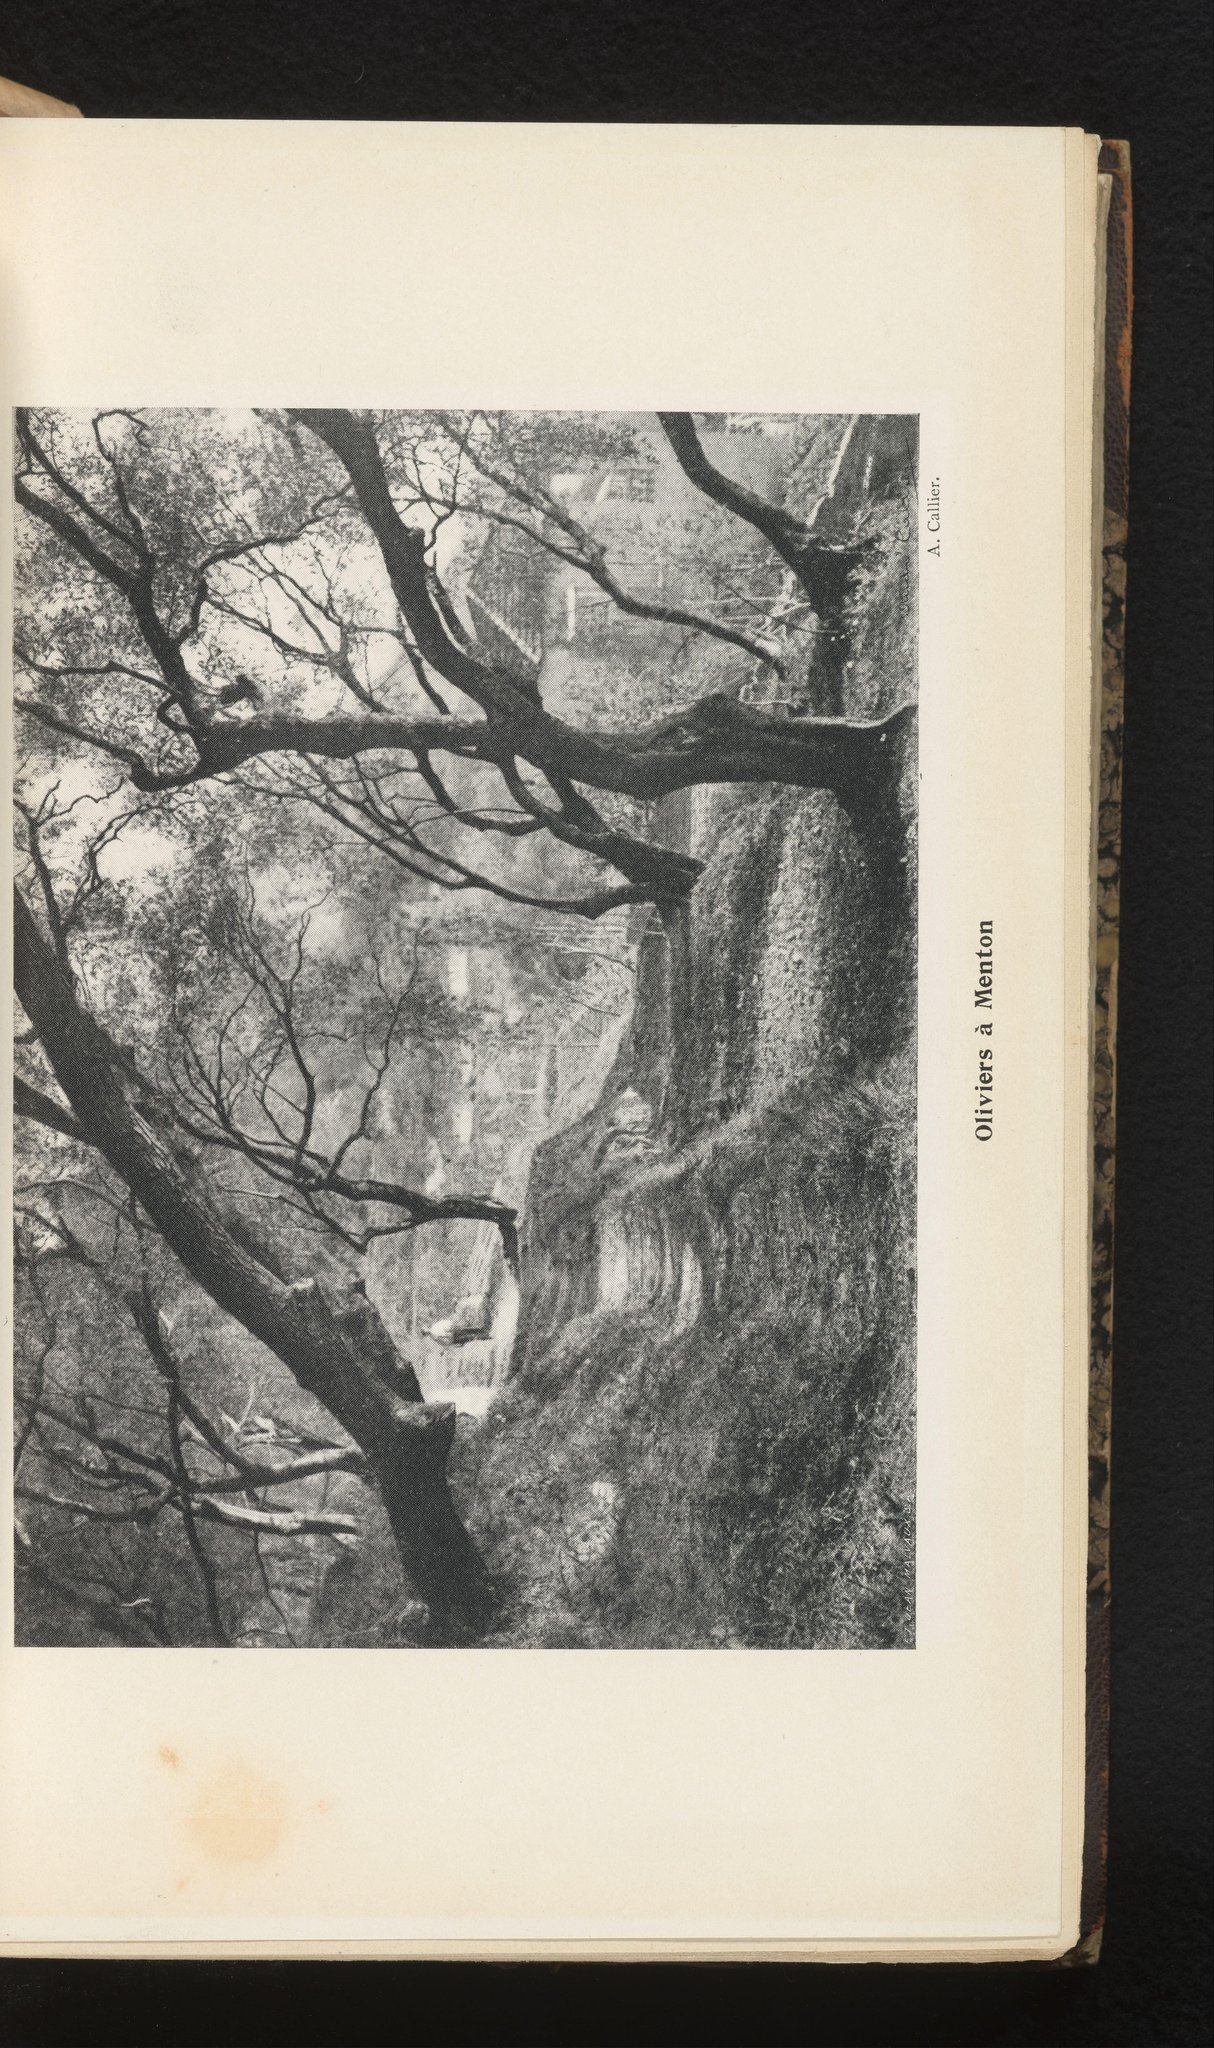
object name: photomechanical print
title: Bospad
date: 1897-1902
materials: paper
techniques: autotype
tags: forest path or lane, trees: olive-tree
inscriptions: inscription: ‘Association belge de photographie’